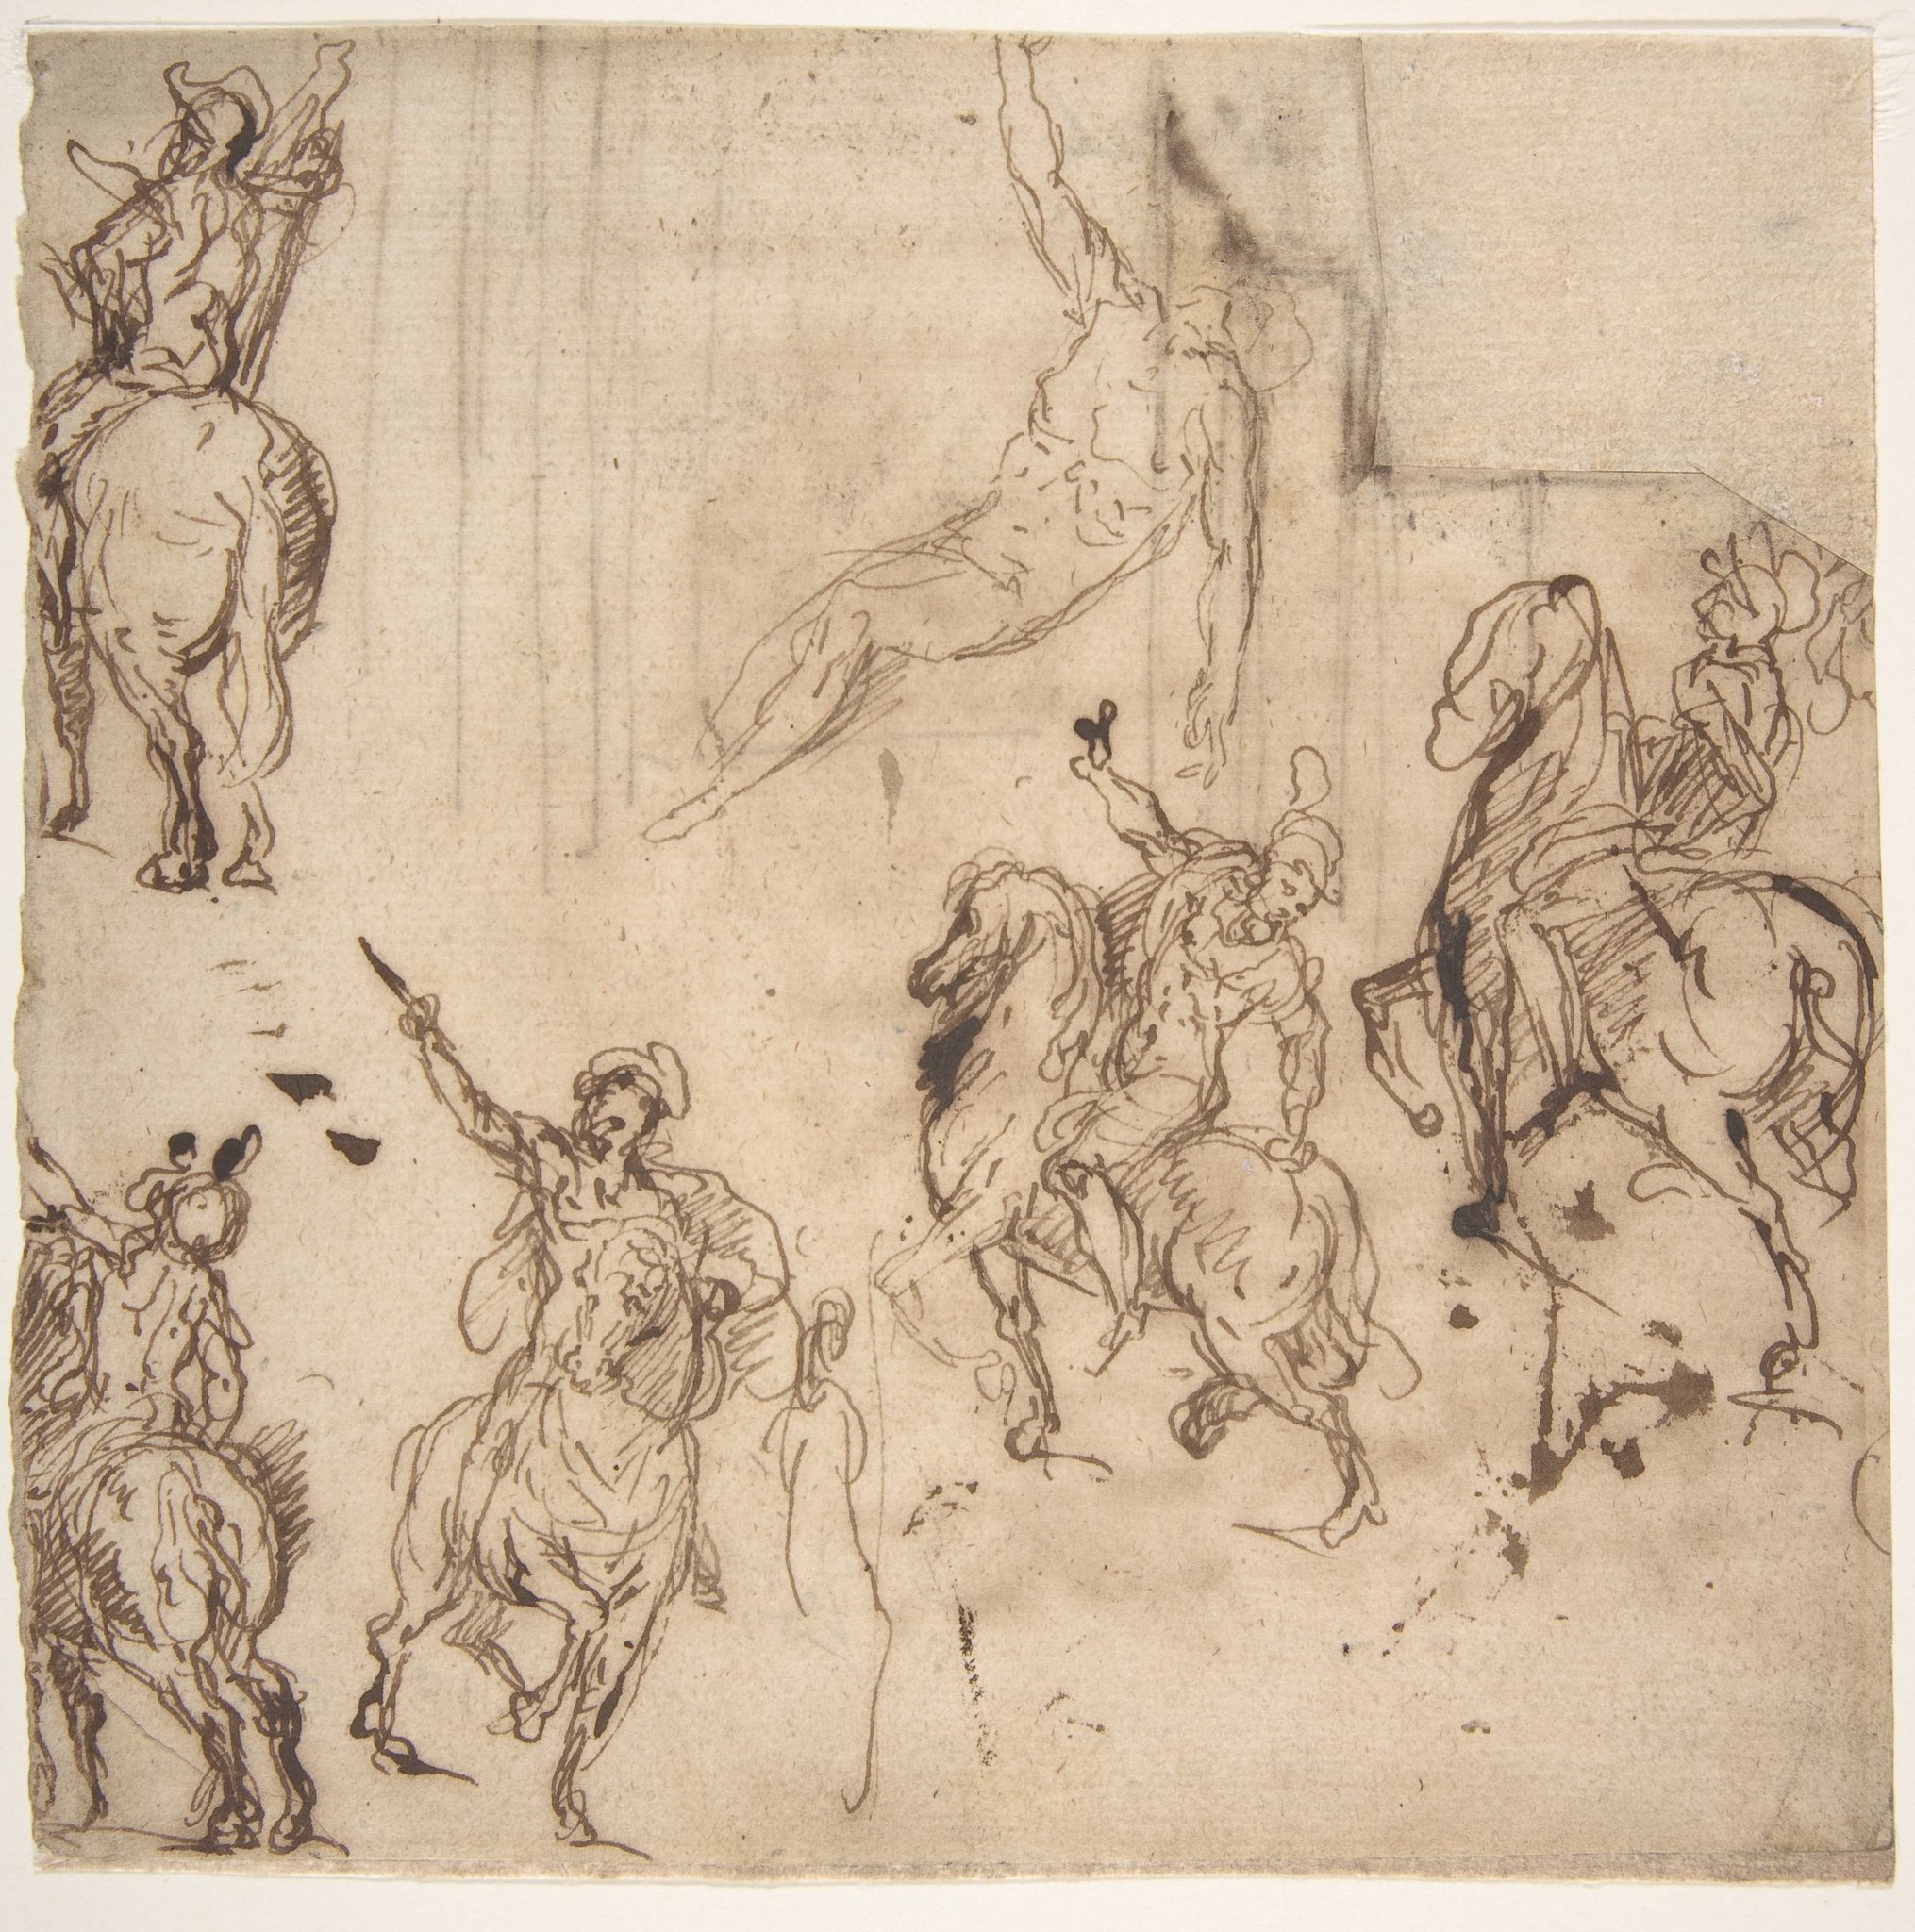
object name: drawing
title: Studies of Horsemen and Study of a Figure for a Deposition (recto); Sketch for an Entablature (verso)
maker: jacopo palma the younger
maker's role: artist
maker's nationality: italian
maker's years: 1543-1628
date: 1548-1628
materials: ink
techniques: pen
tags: human figures,bow and arrow,horses